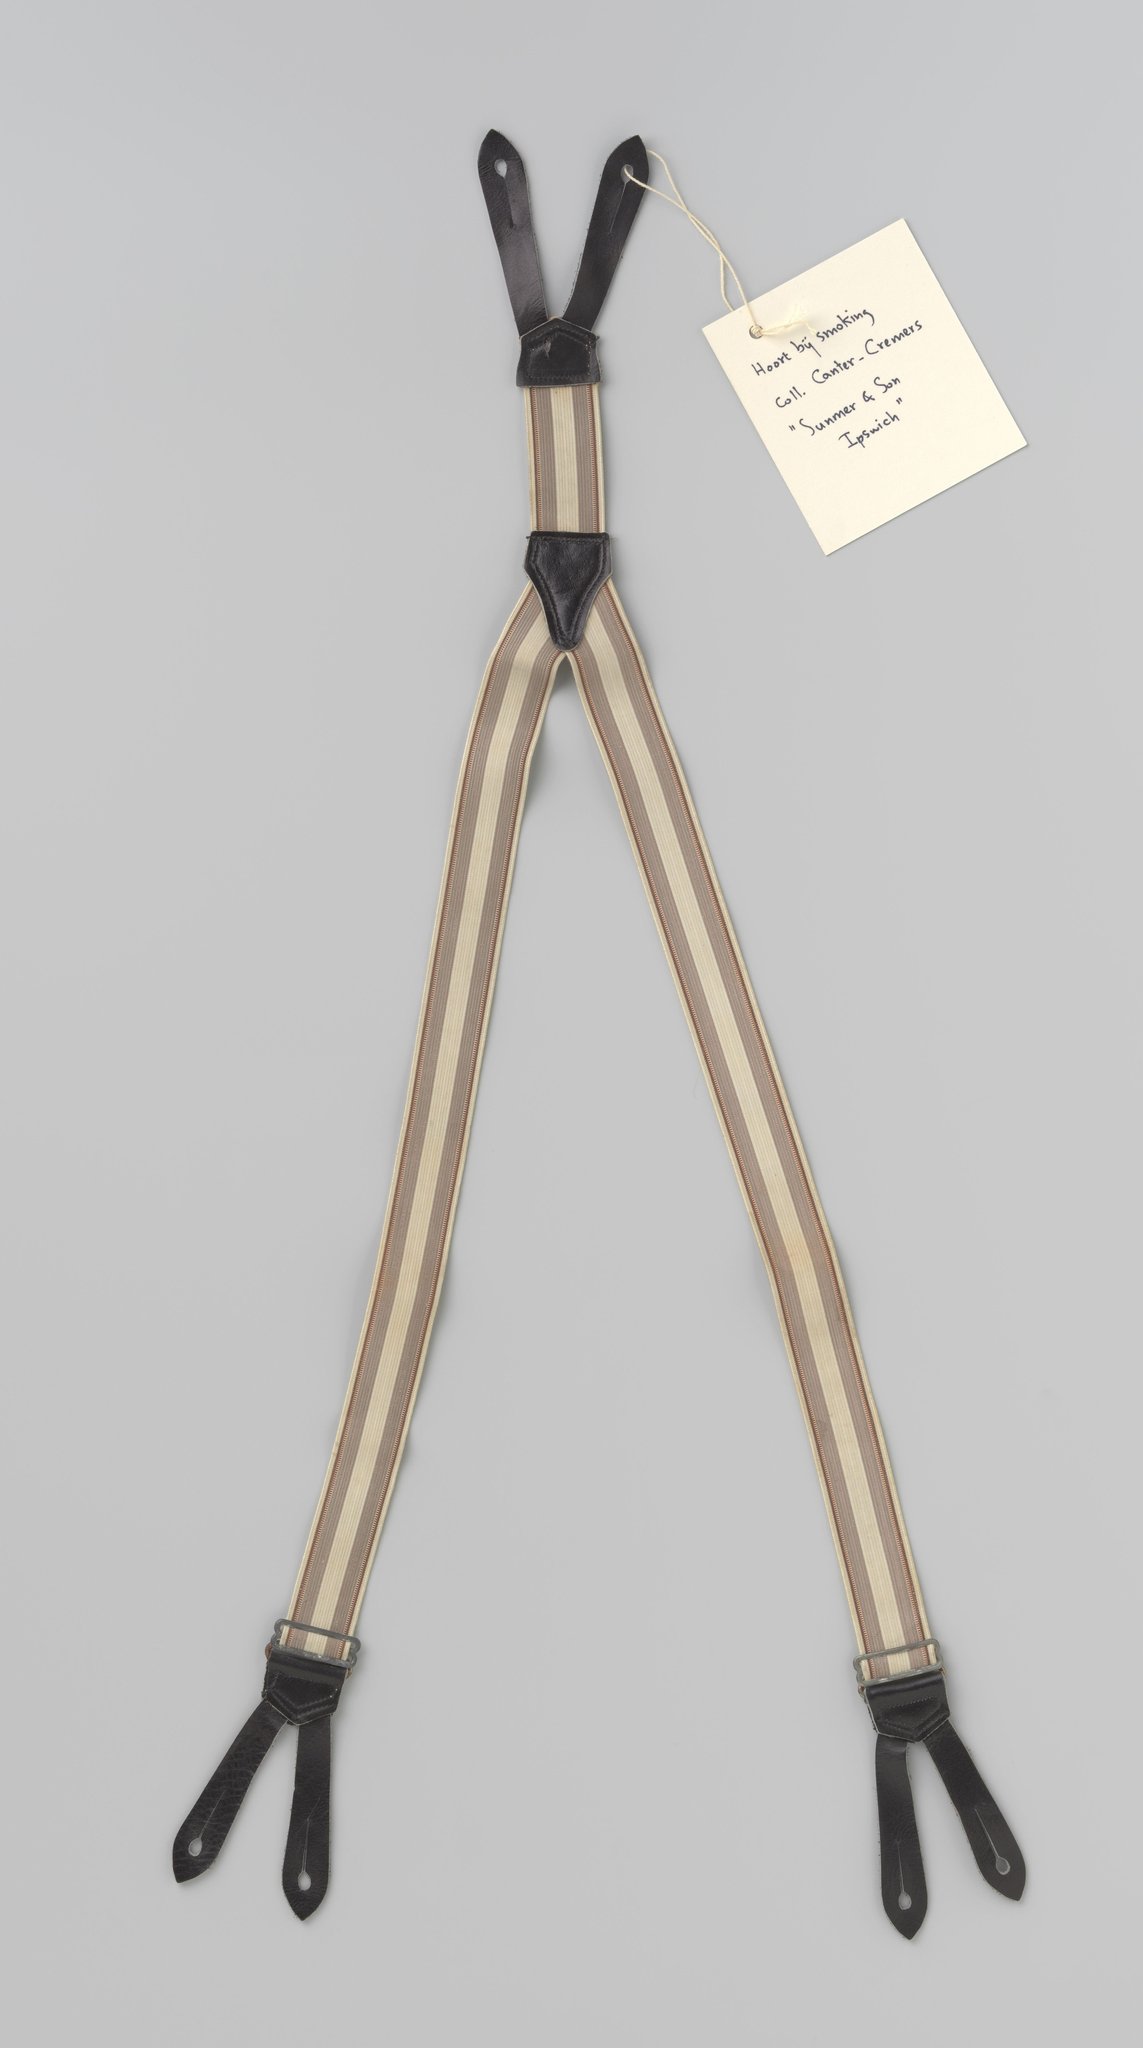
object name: menswear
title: Grijze bretels met witte biezen, leren bevestigingsonderdelen en goudkleurige gespen, evenals de goudkleurige drukkers gemerkt met "hold up"; in pen gemerkt: CC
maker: Anonymous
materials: leather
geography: europe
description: Grijze bretels met witte biezen, leren bevestigingsonderdelen en goudkleurige gespen, evenals de goudkleurige drukkers gemerkt met "hold up"; in pen gemerkt: CC. Canter Cremers.